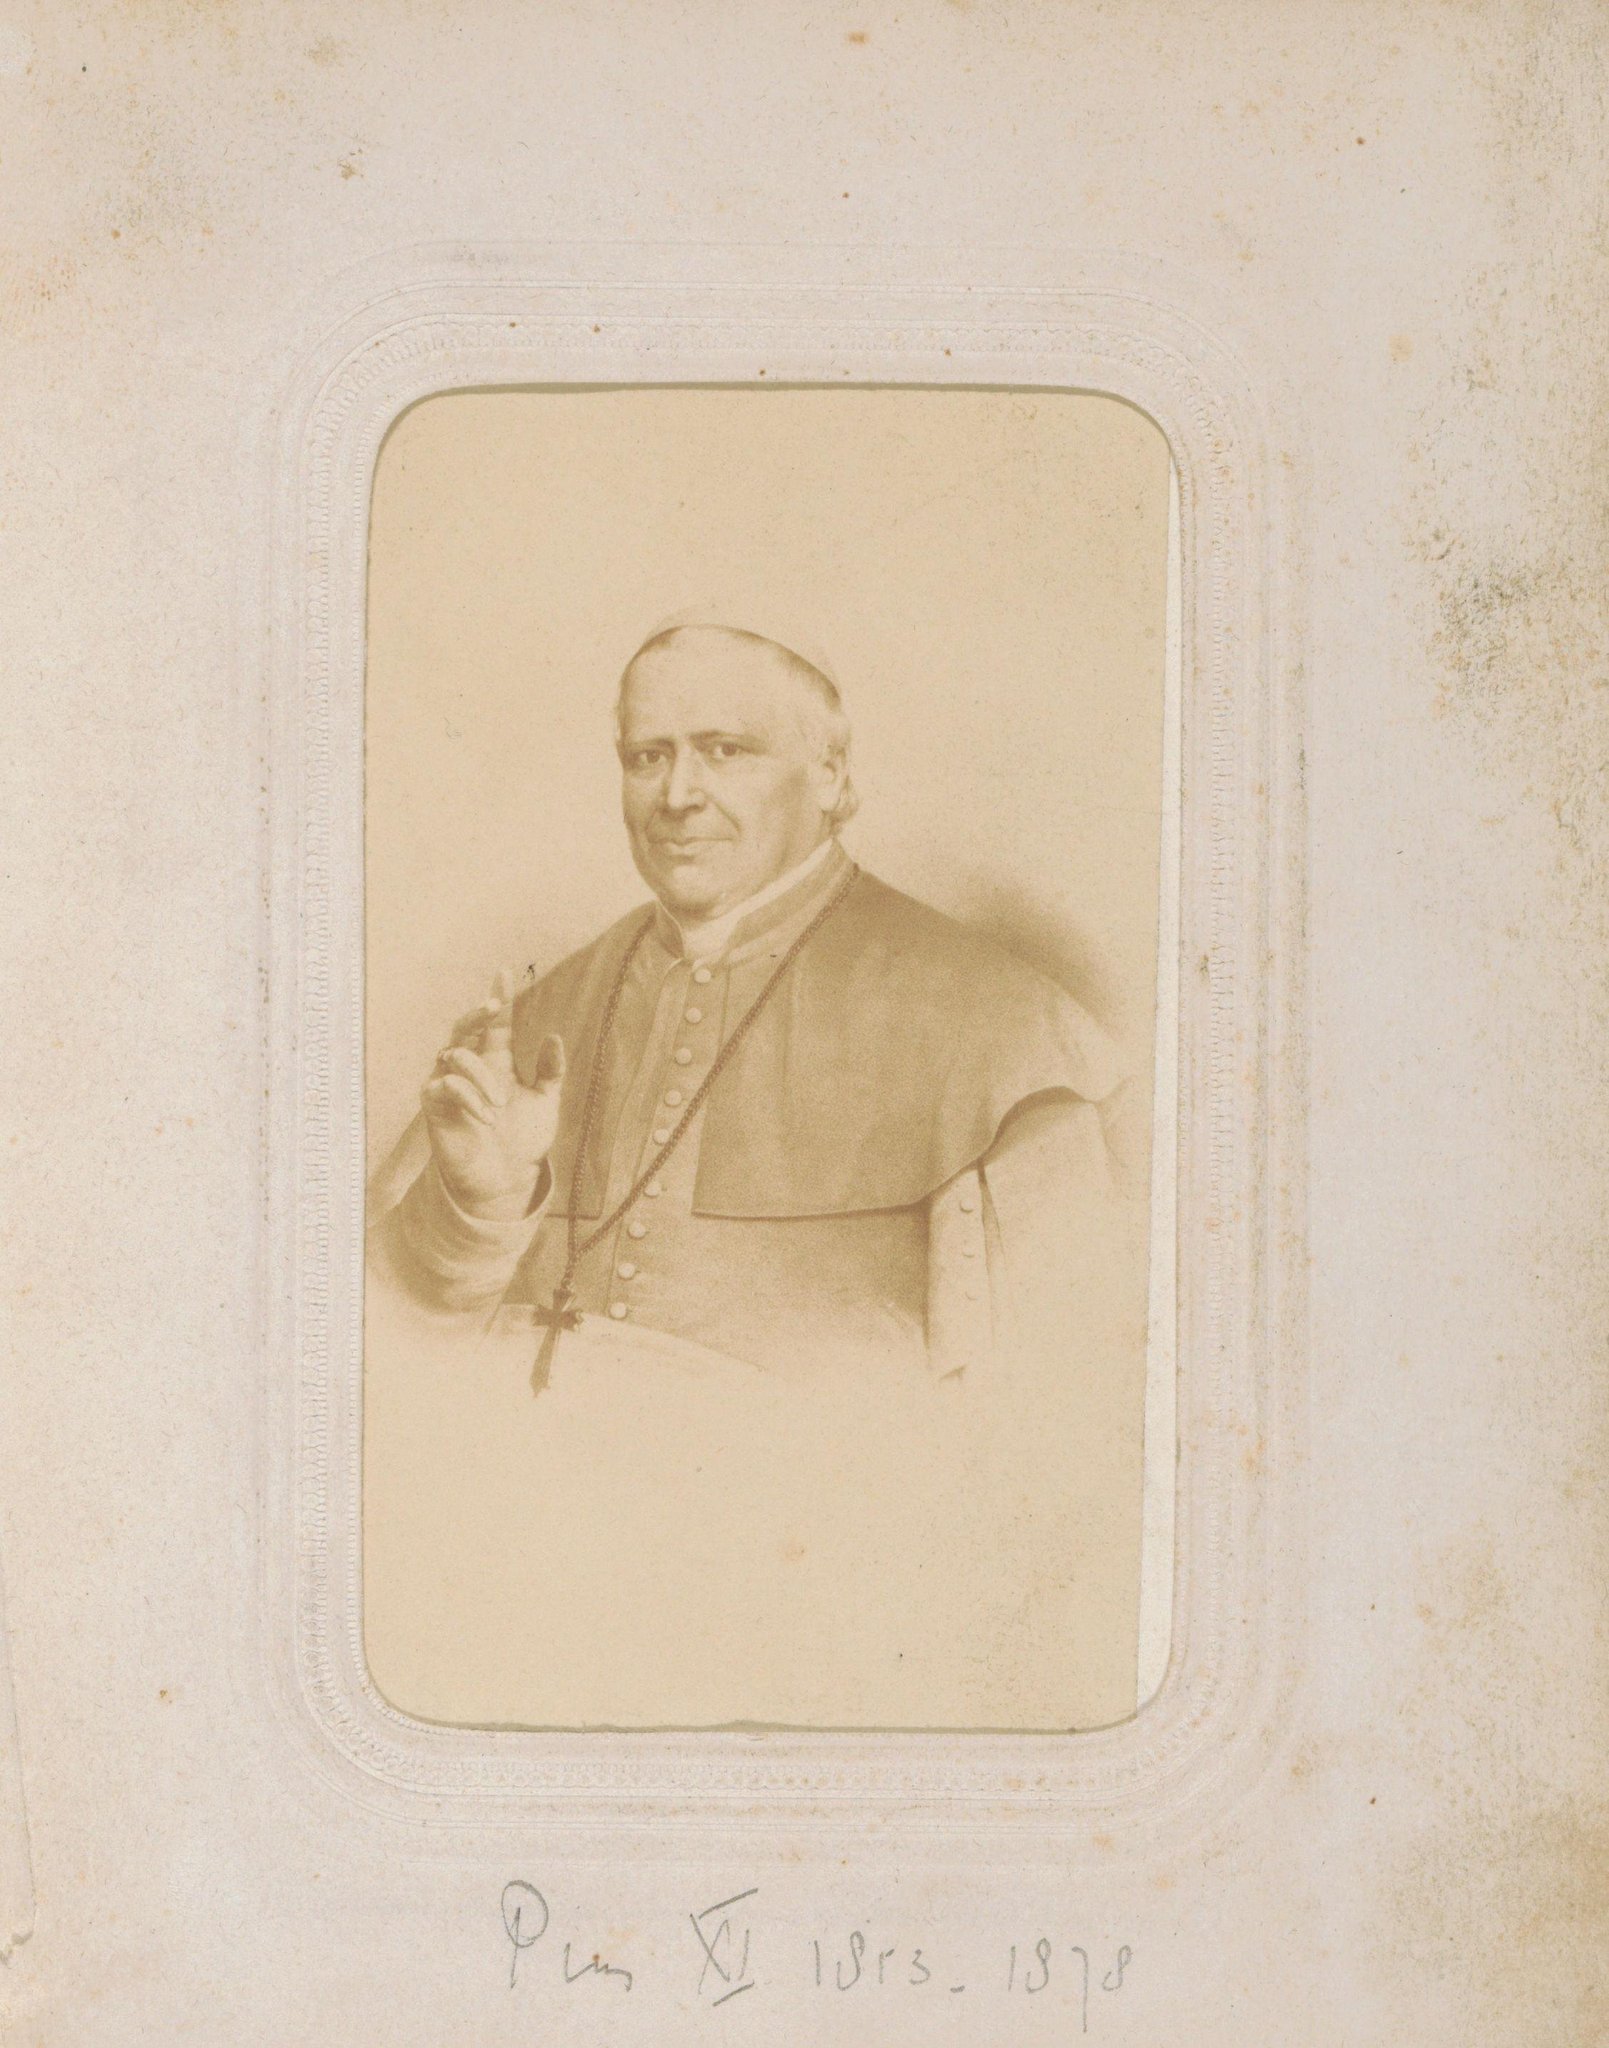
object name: carte de visite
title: Fotoreproductie van (vermoedelijk) een tekening van paus Pius IX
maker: Anonymous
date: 1860-1880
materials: cardboard, paper, photographic support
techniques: albumen print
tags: rome, pope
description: Onderdeel van Fotoalbum met 26 cartes-de-visite van rooms-katholieke geestelijken.